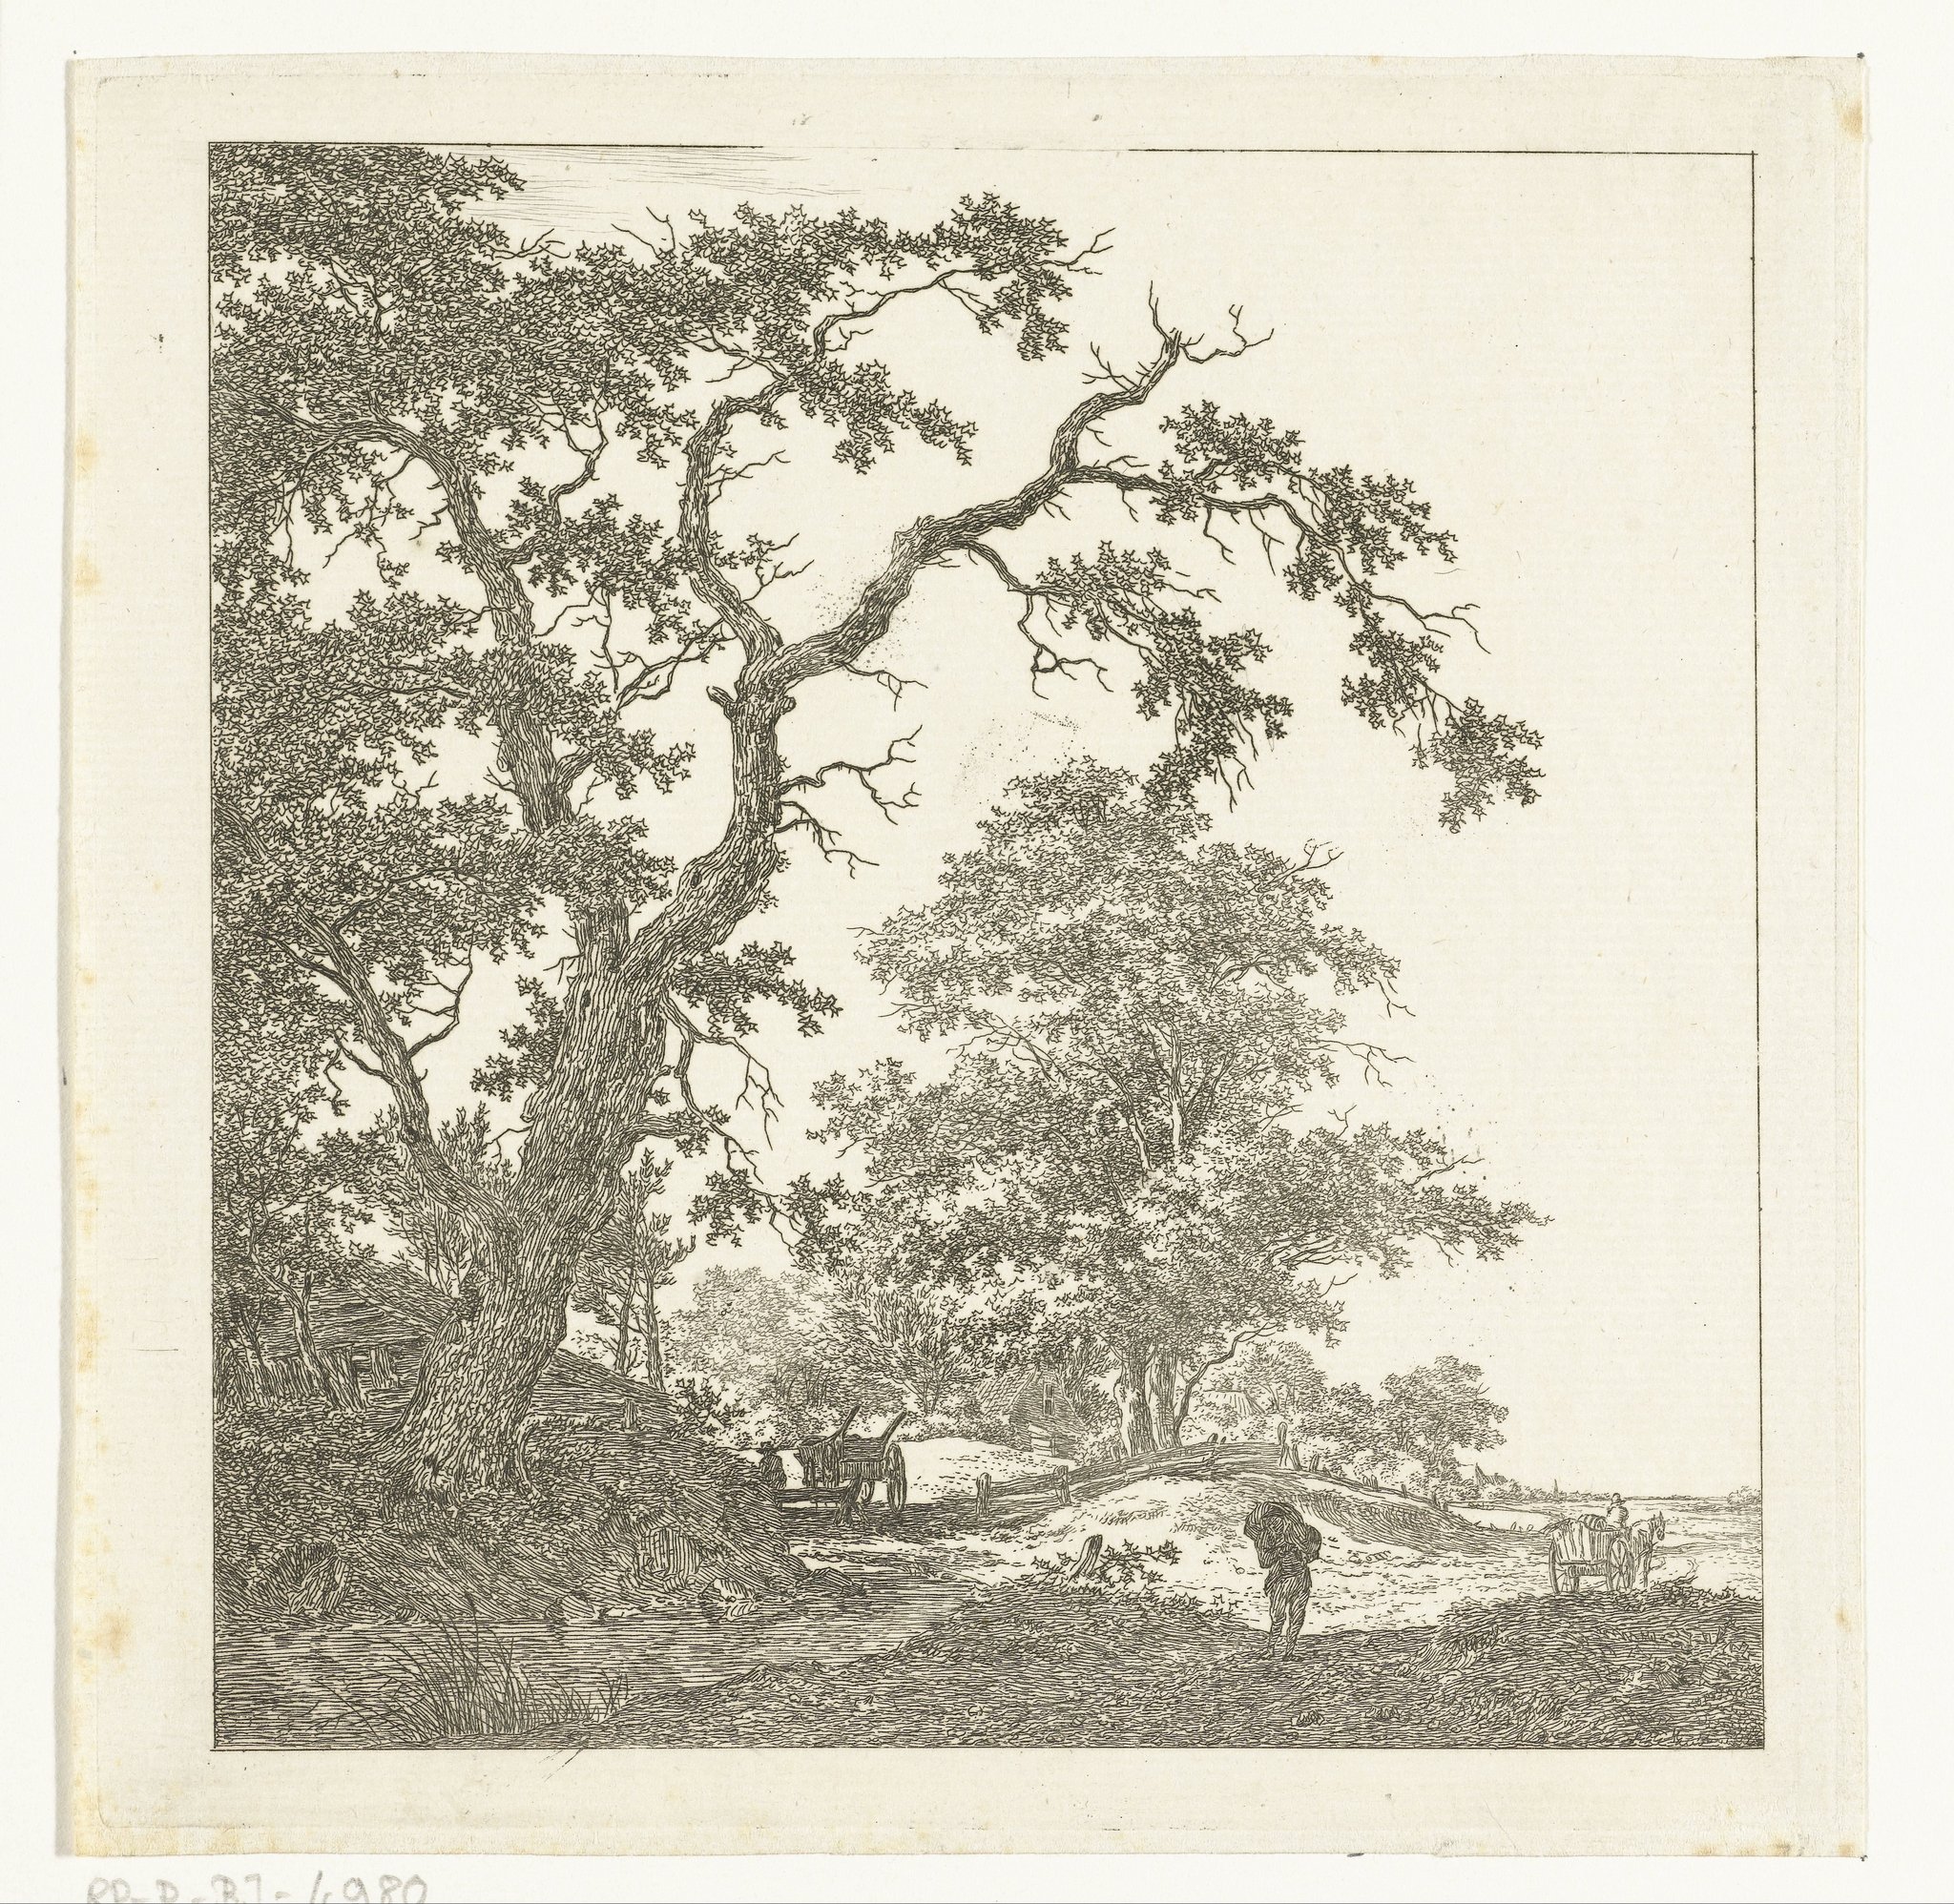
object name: print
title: Kruisend zandpad met karren en man met pak op zijn rug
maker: hermanus van brussel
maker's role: draughtsman, print maker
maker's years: 1763-1815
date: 1800-1815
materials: paper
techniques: etching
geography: netherlands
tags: landscapes in the temperate zone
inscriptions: collector's mark: Lugt 2228